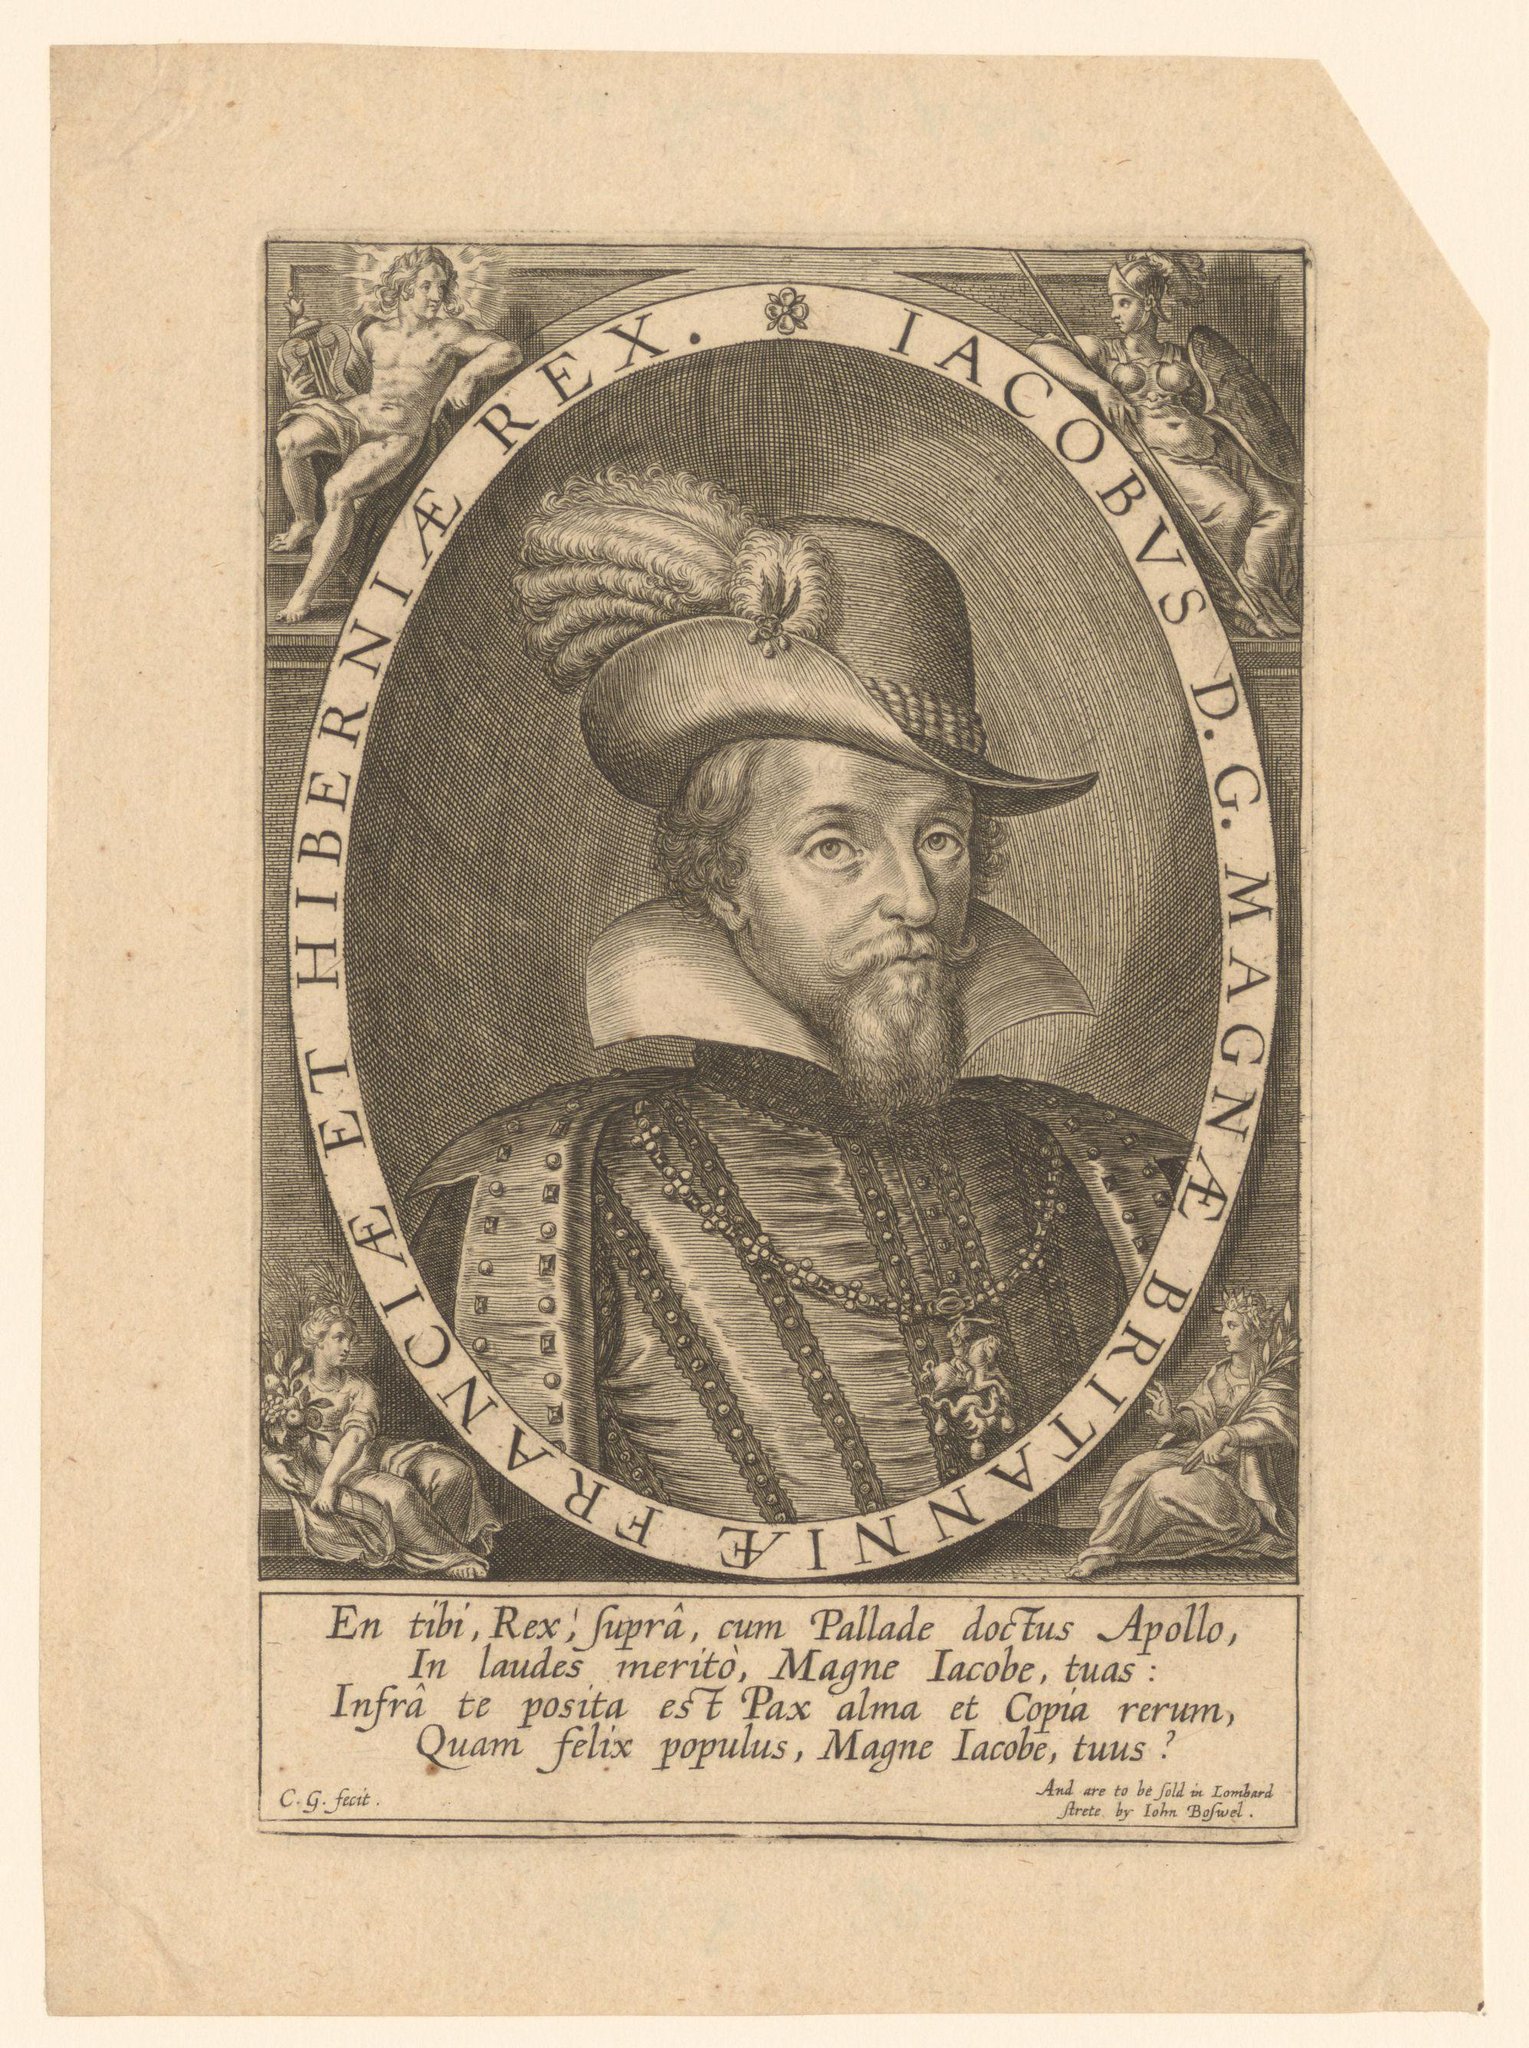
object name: print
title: Portret van Jacobus I, koning van Engeland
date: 1610-1620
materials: paper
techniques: engraving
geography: london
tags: jacobus i (koning van engeland), historical persons, king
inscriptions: collector's mark: Lugt 2228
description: Tekst in het Latijn in de omlijsting en in de ondermarge.